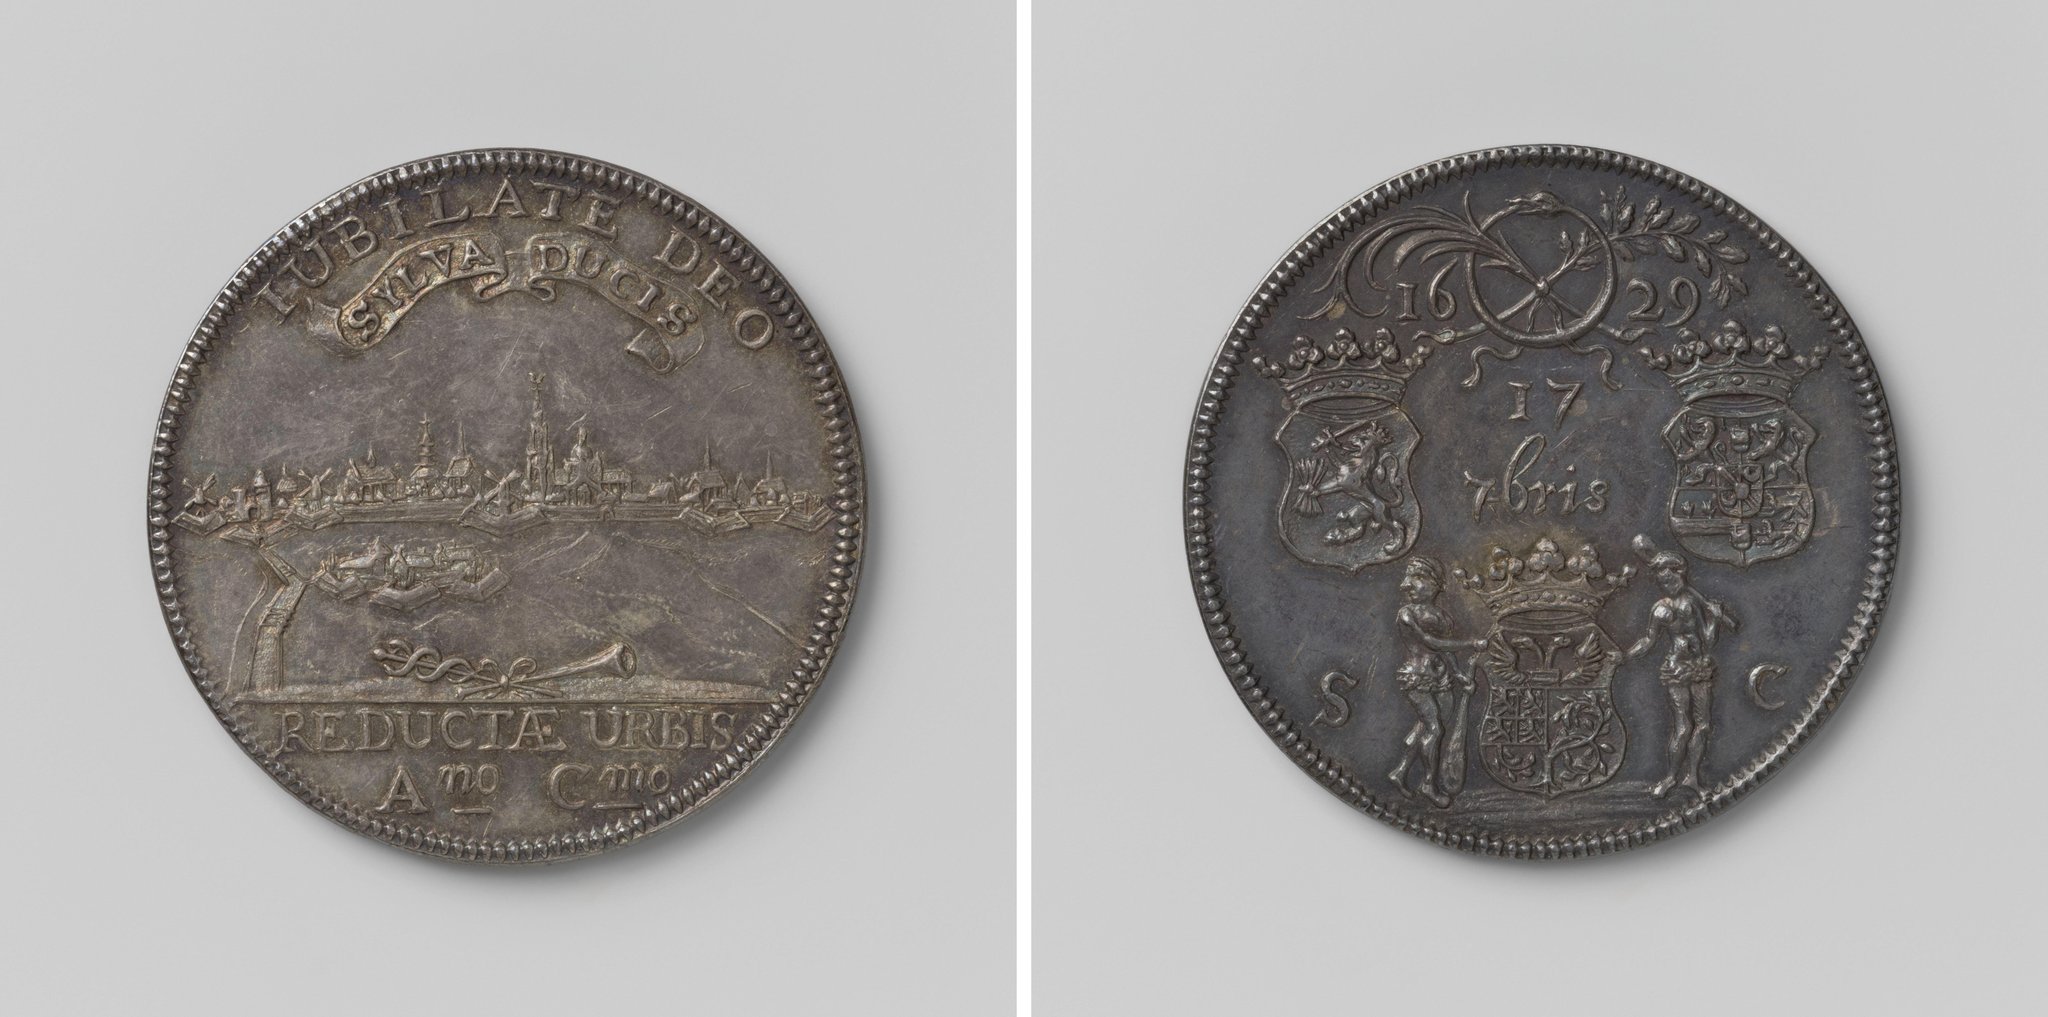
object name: council medal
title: 's-Hertogenbosch, vroedschapspenning op het eeuwfeest van de inname van de stad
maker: theodorus casparus van berckel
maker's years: 1680-1734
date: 1729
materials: silver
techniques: striking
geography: den bosch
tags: den bosch